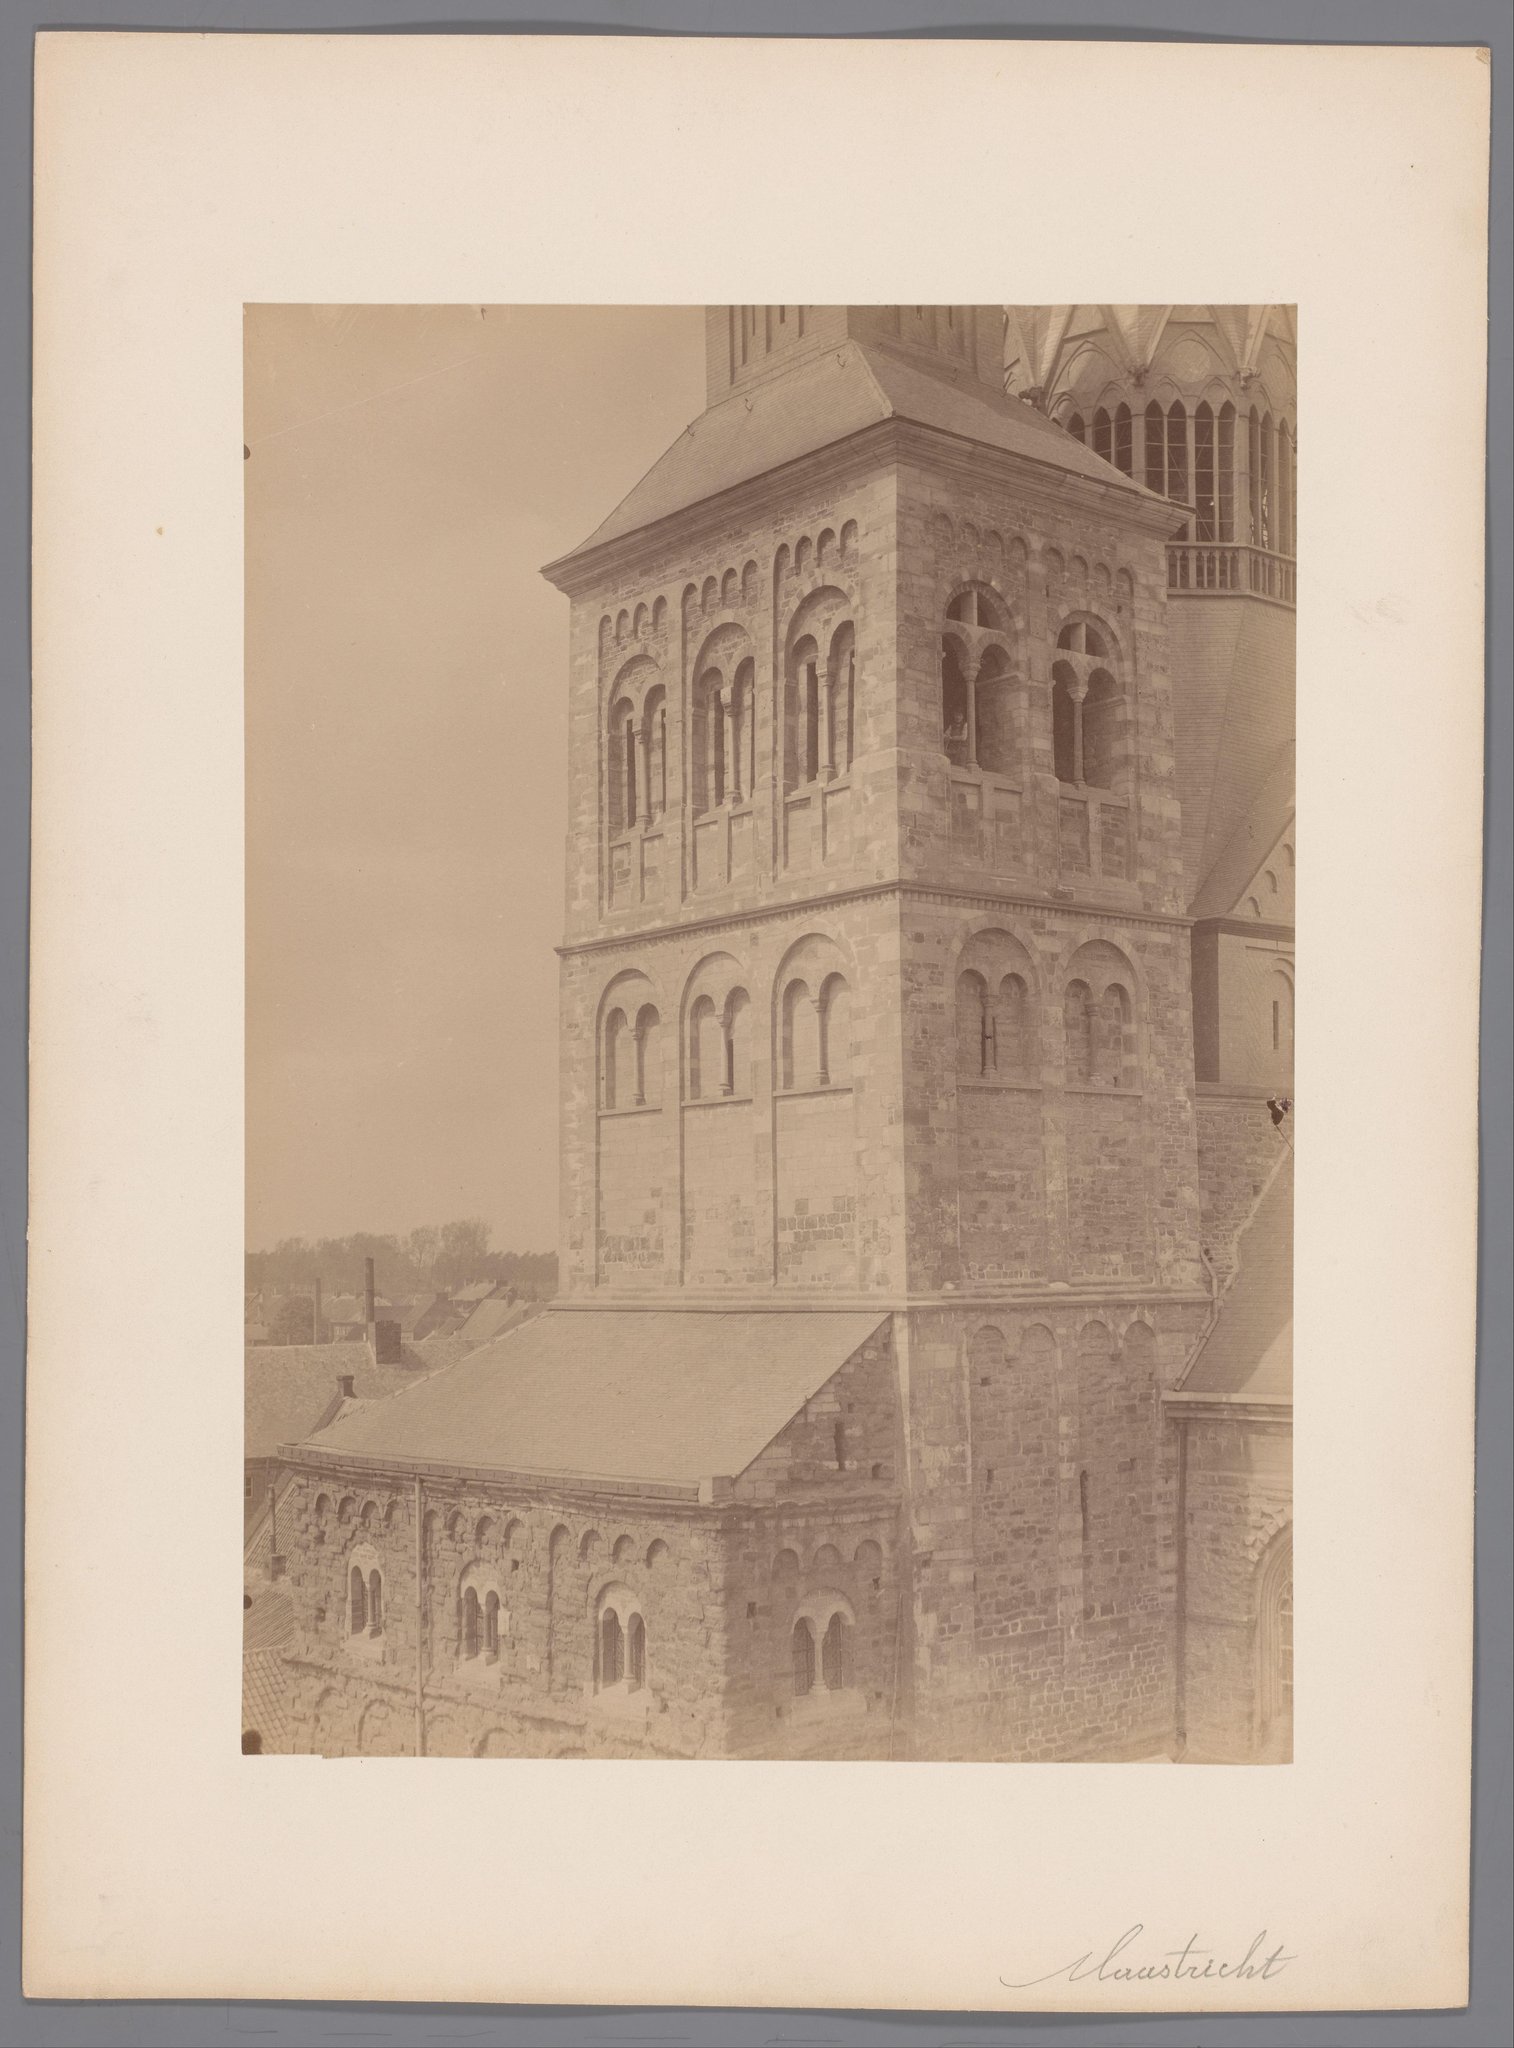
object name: photograph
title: Gedeelte van de zuidelijke toren van de Sint-Servaasbasiliek te Maastricht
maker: anoniem (monumentenzorg)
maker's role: fotograaf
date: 1893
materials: cardboard, photographic support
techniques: albumen print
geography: maastricht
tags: parts of church exterior and annexes: tower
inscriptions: annotation: ‘Maastricht’, annotation: ‘St. Servaaskerk Maastricht/ gezicht op de torens (detail) gezien van af de noordelijke omgang van den S. Janskerk toren/ Mei 1893’